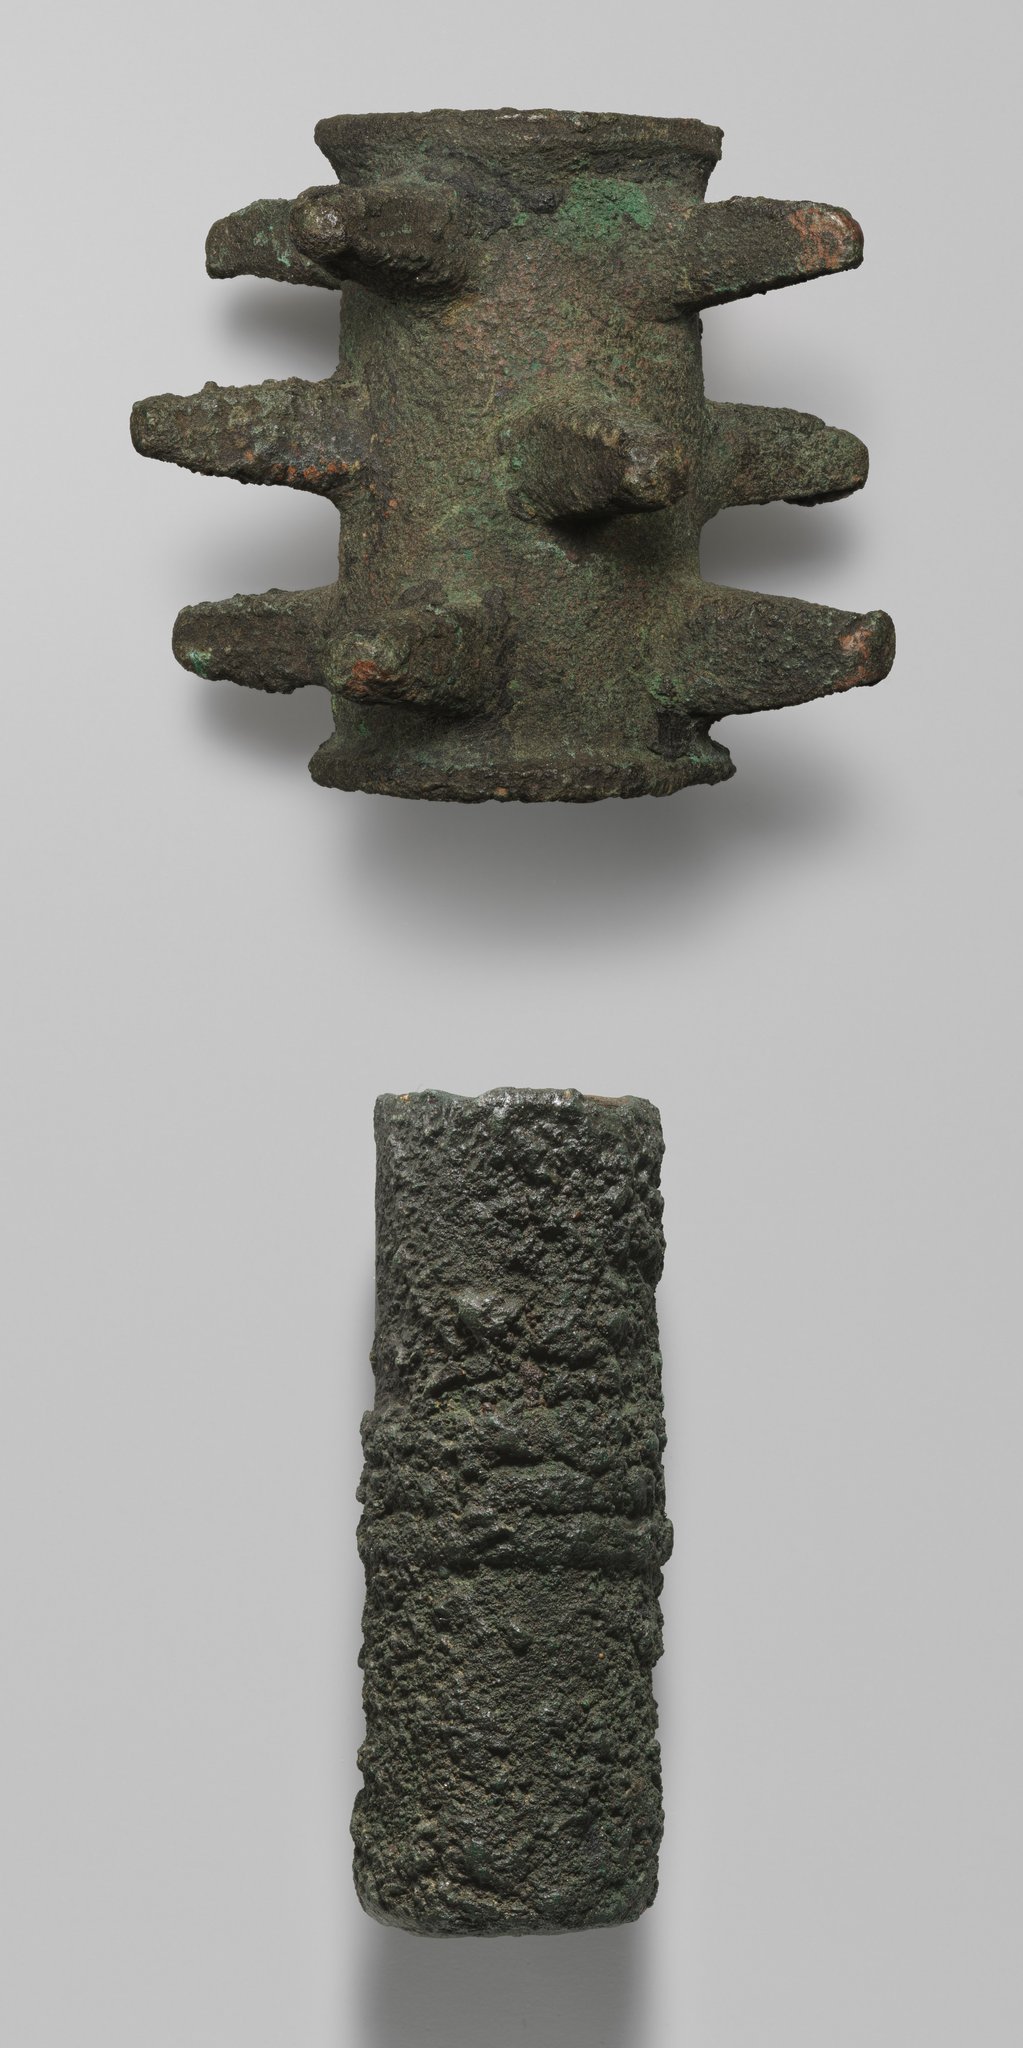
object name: mace head, ferrule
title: Mace head and ferrule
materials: copper alloy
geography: egypt